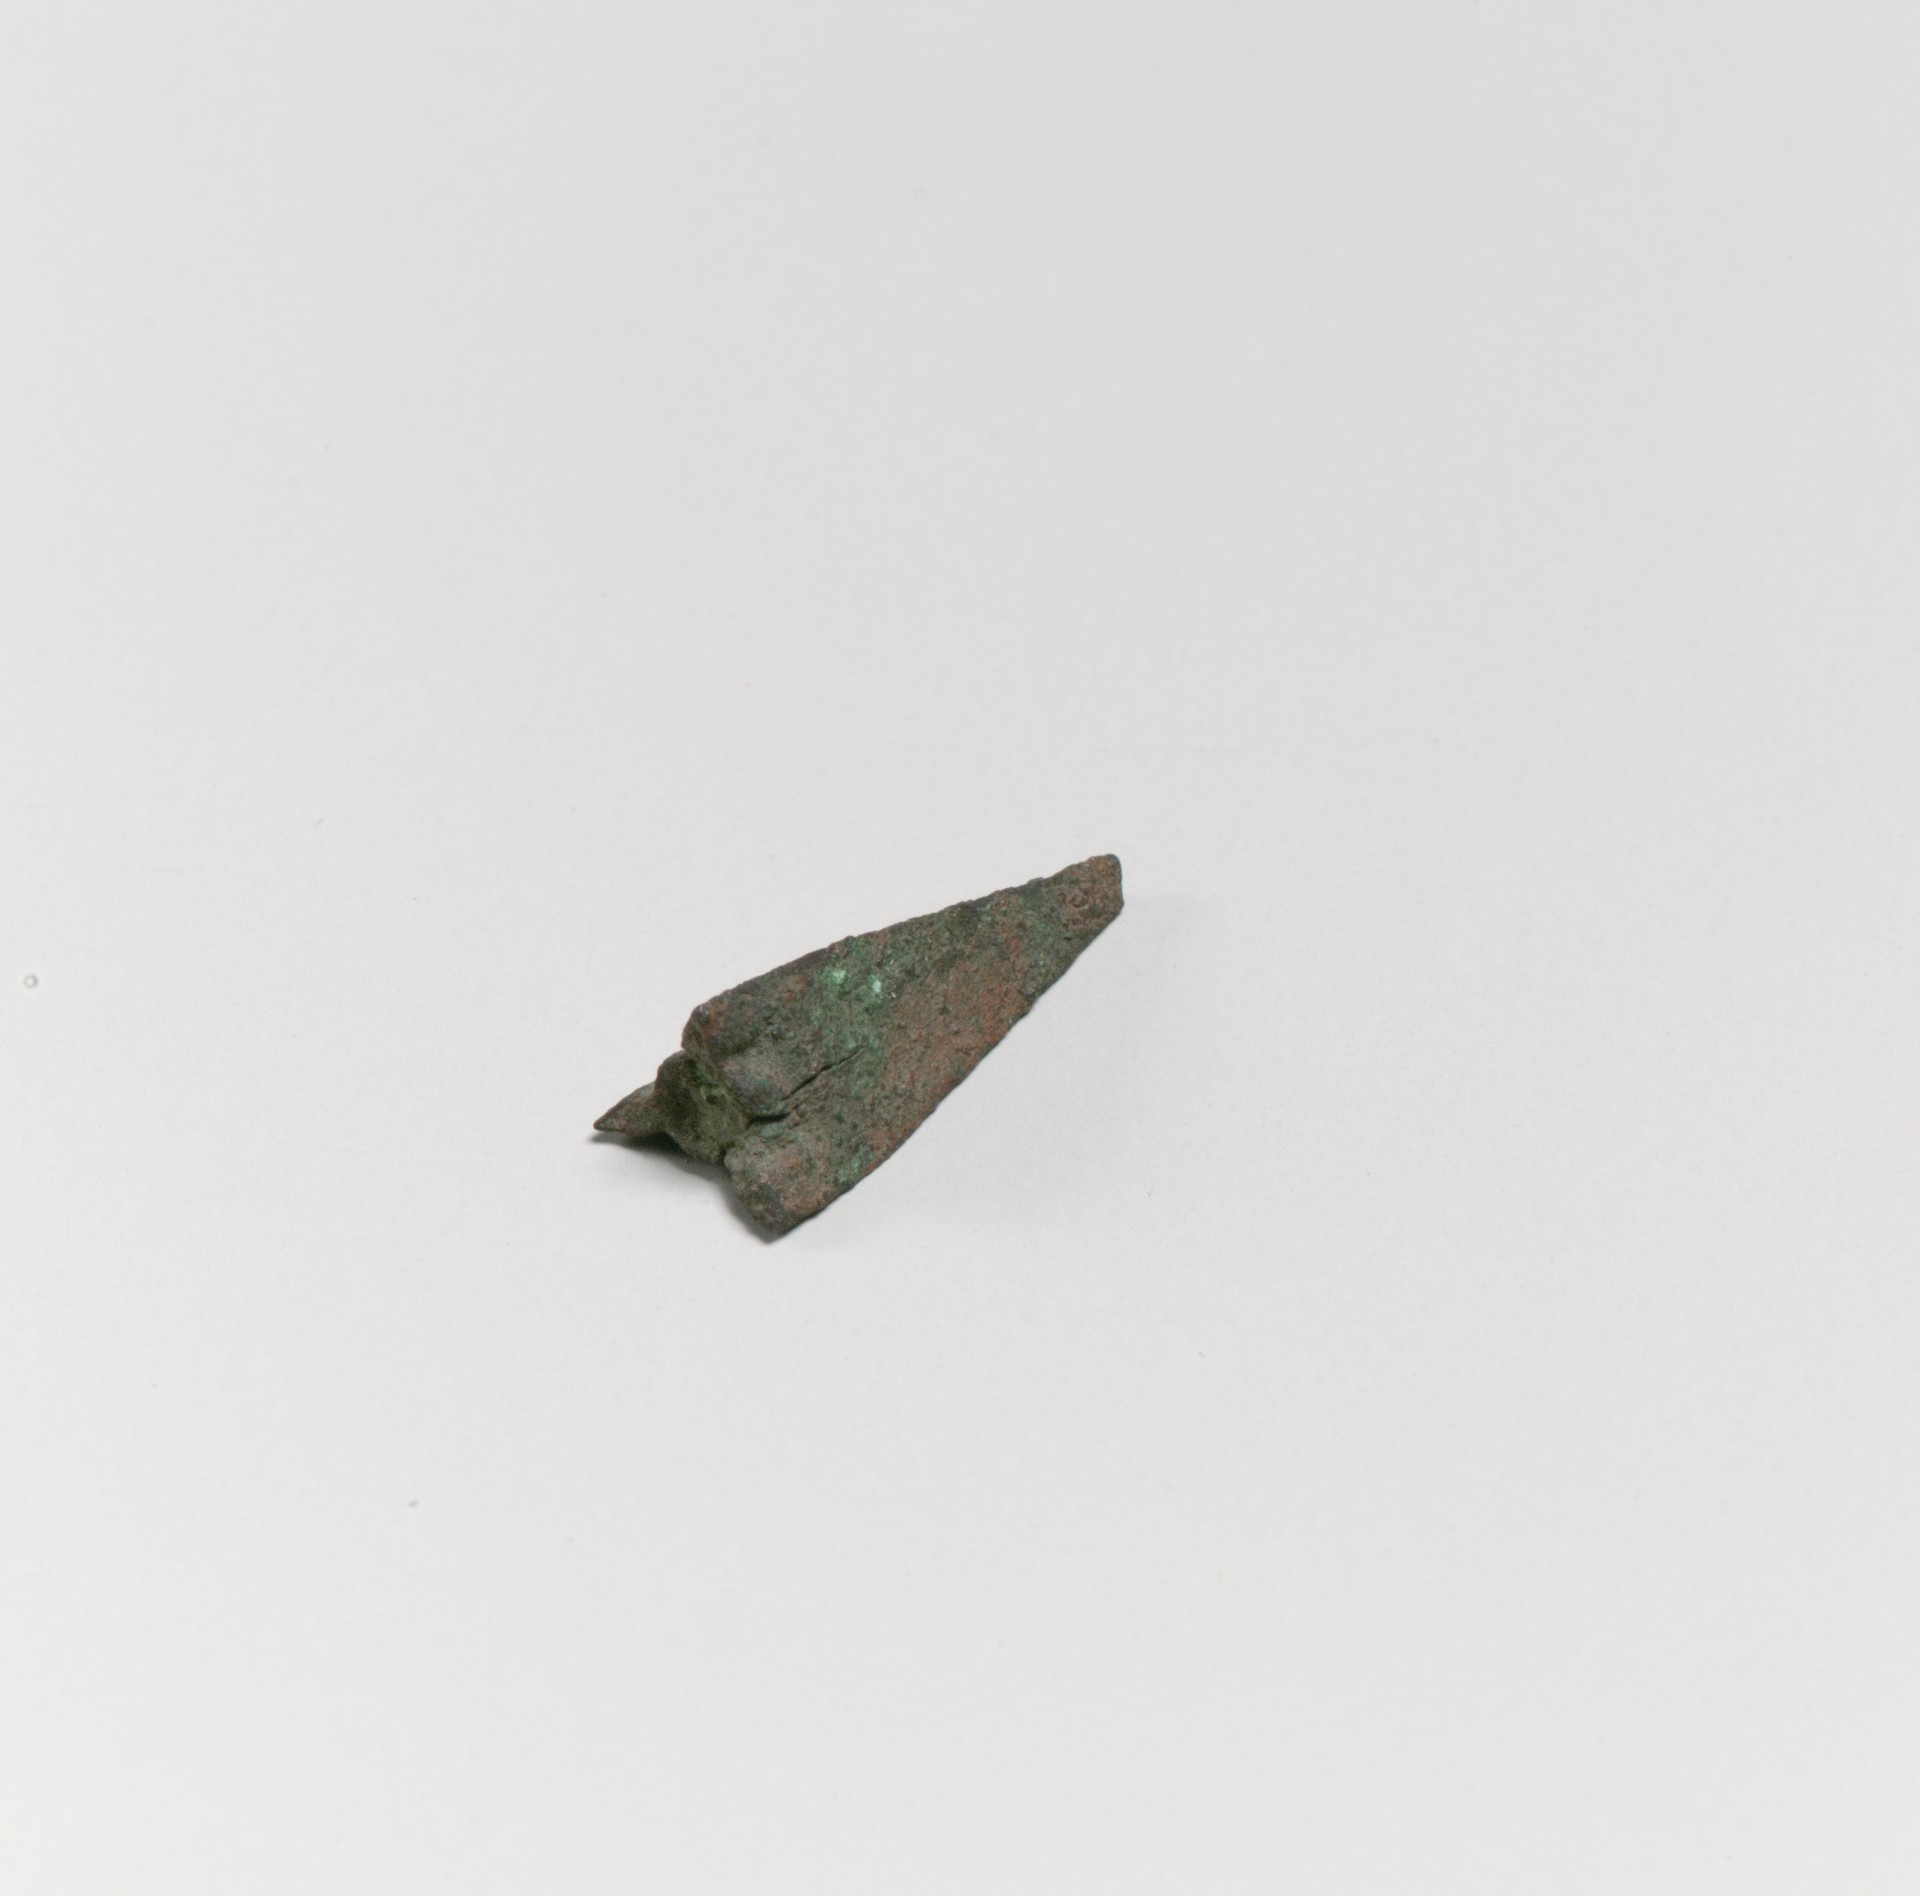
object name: arrowhead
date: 7000 BCE-330 CE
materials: bronze